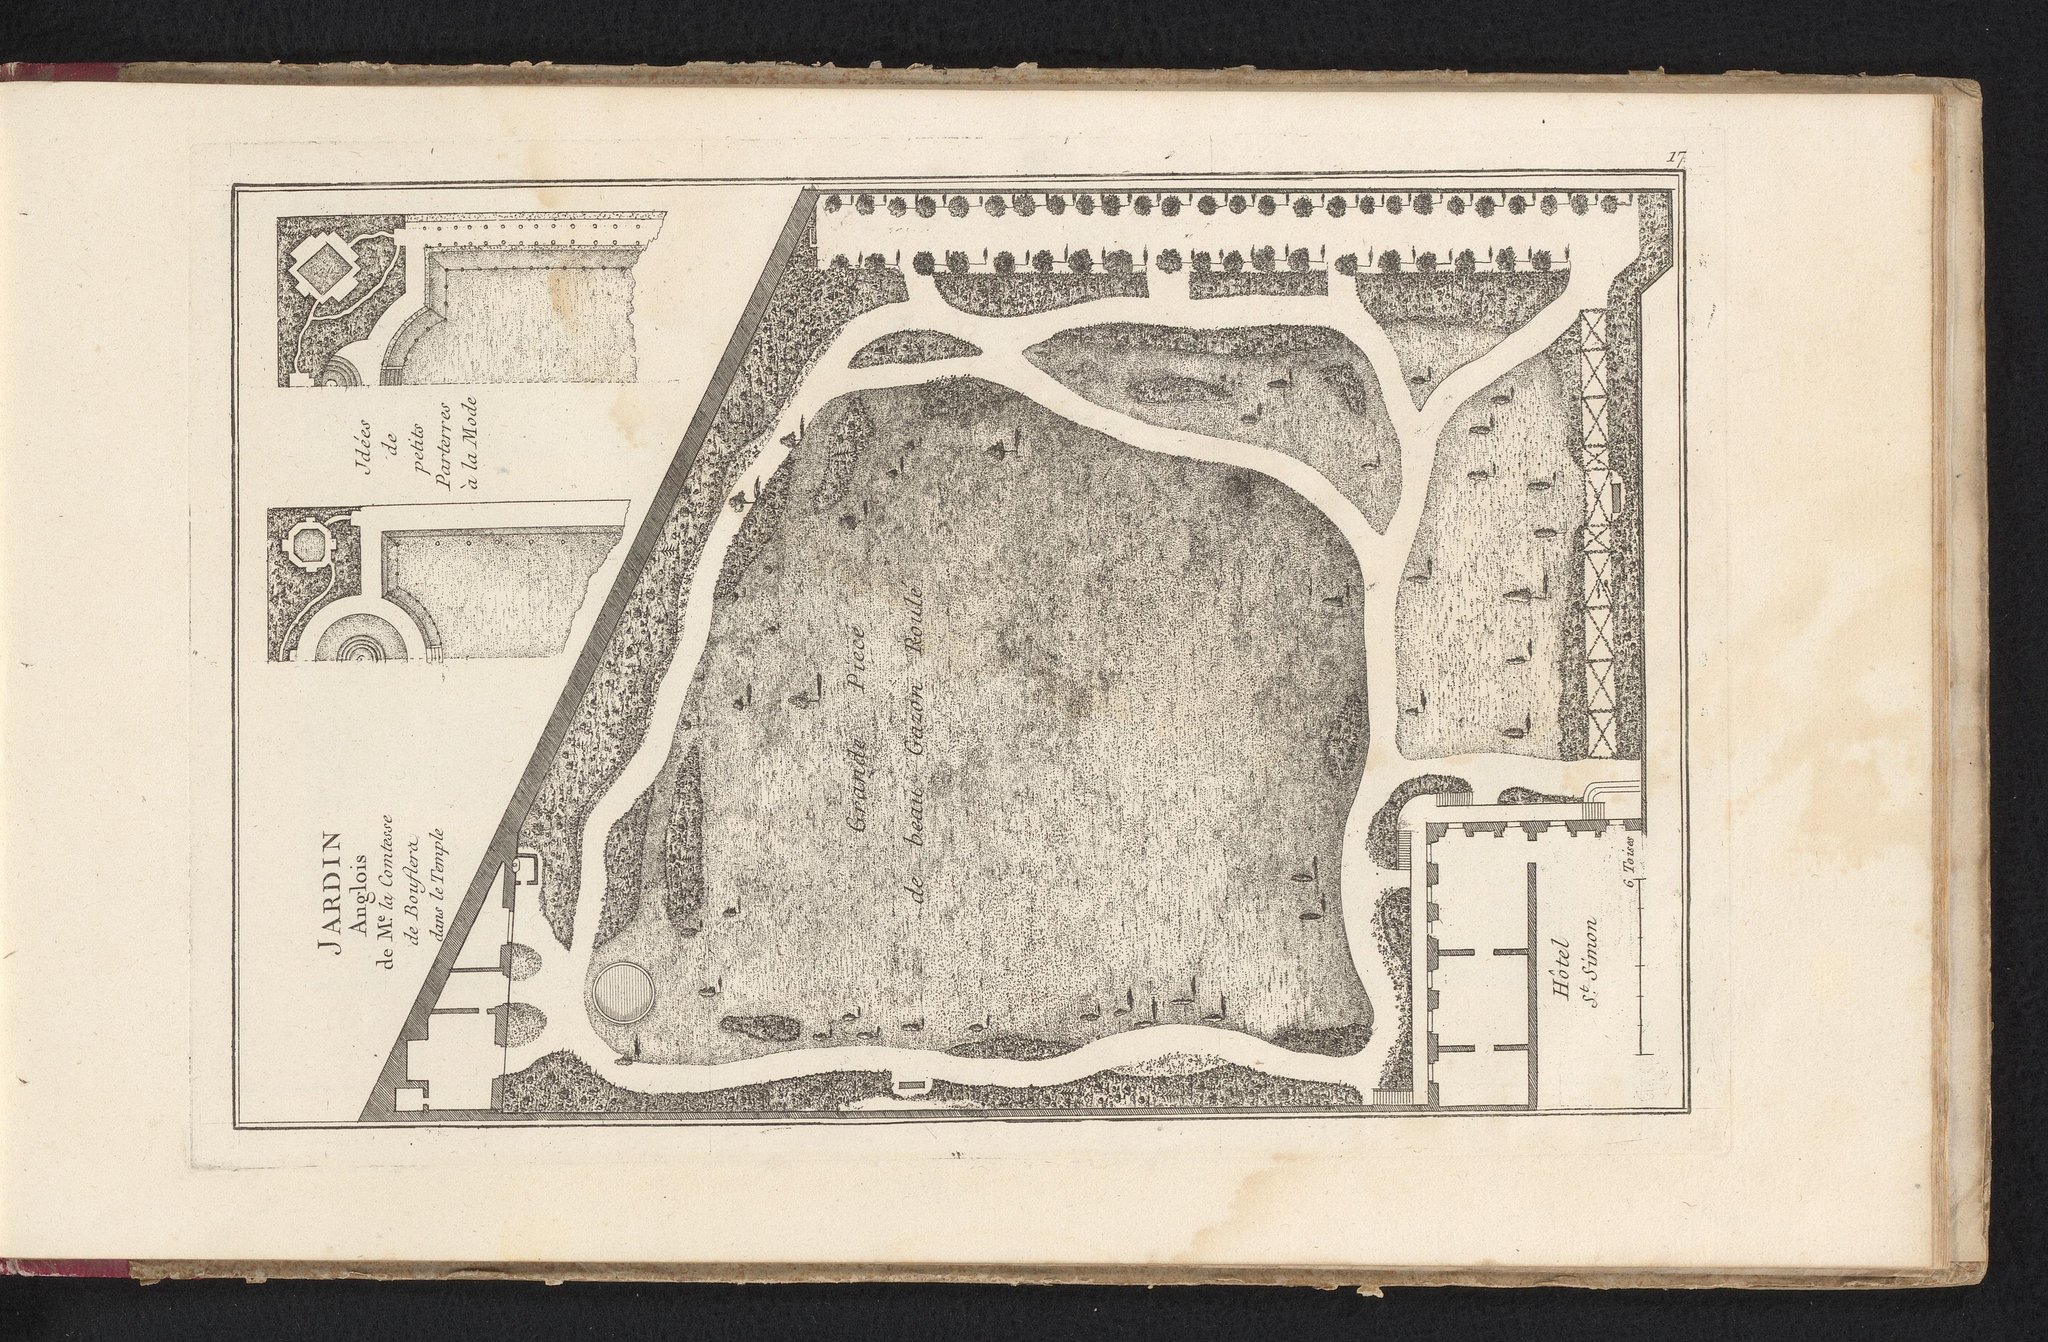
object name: album leaf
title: Jardins anglo-chinois à la mode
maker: Anonymous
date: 1775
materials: paper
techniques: engraving, etching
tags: plan, map of garden, paris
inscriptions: collector's mark: Lugt 2760, collector's mark: Lugt 2228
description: De serie 'Jardins anglo-chinois à la mode' verscheen in totaal in 21 zogeheten 'cahiers' (afleveringen). De huidige prent komt uit het tweede 'cahier'. Het Rijksmuseum Amsterdam bezit drie banden met daarin in totaal zes 'cahiers' van deze reeks. In de documentatie wordt verwezen naar een in de bibliotheek van het Rijksmuseum Amsterdam aanwezige facsimile van het complete werk.